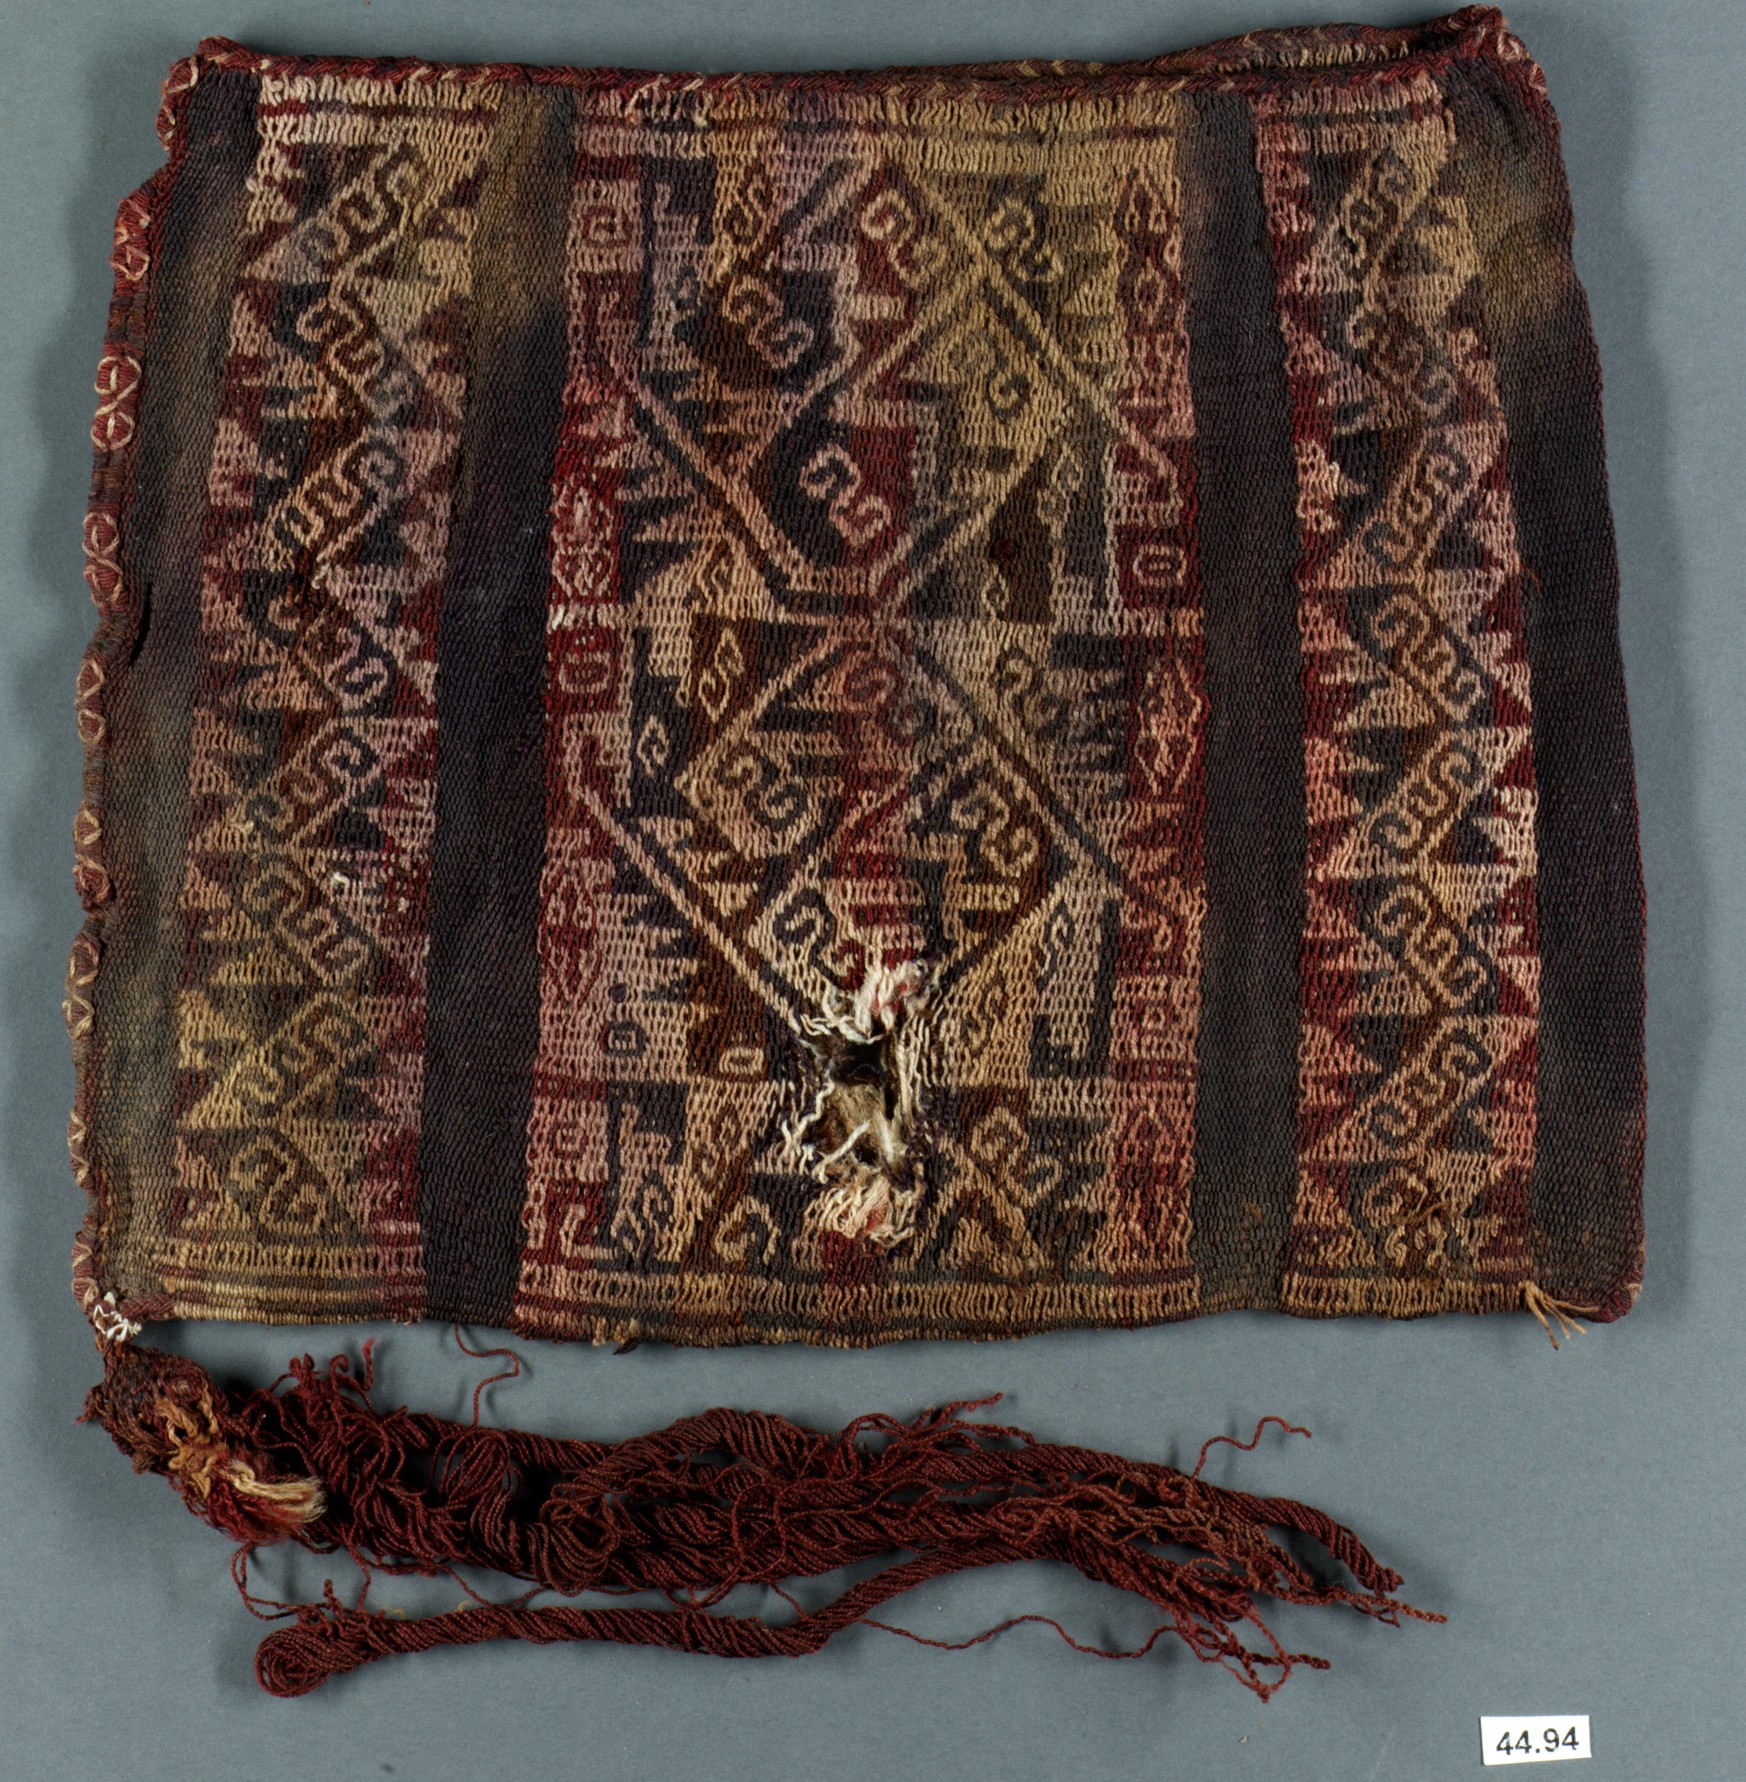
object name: bag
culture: arica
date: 1101-1500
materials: animal fiber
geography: chile